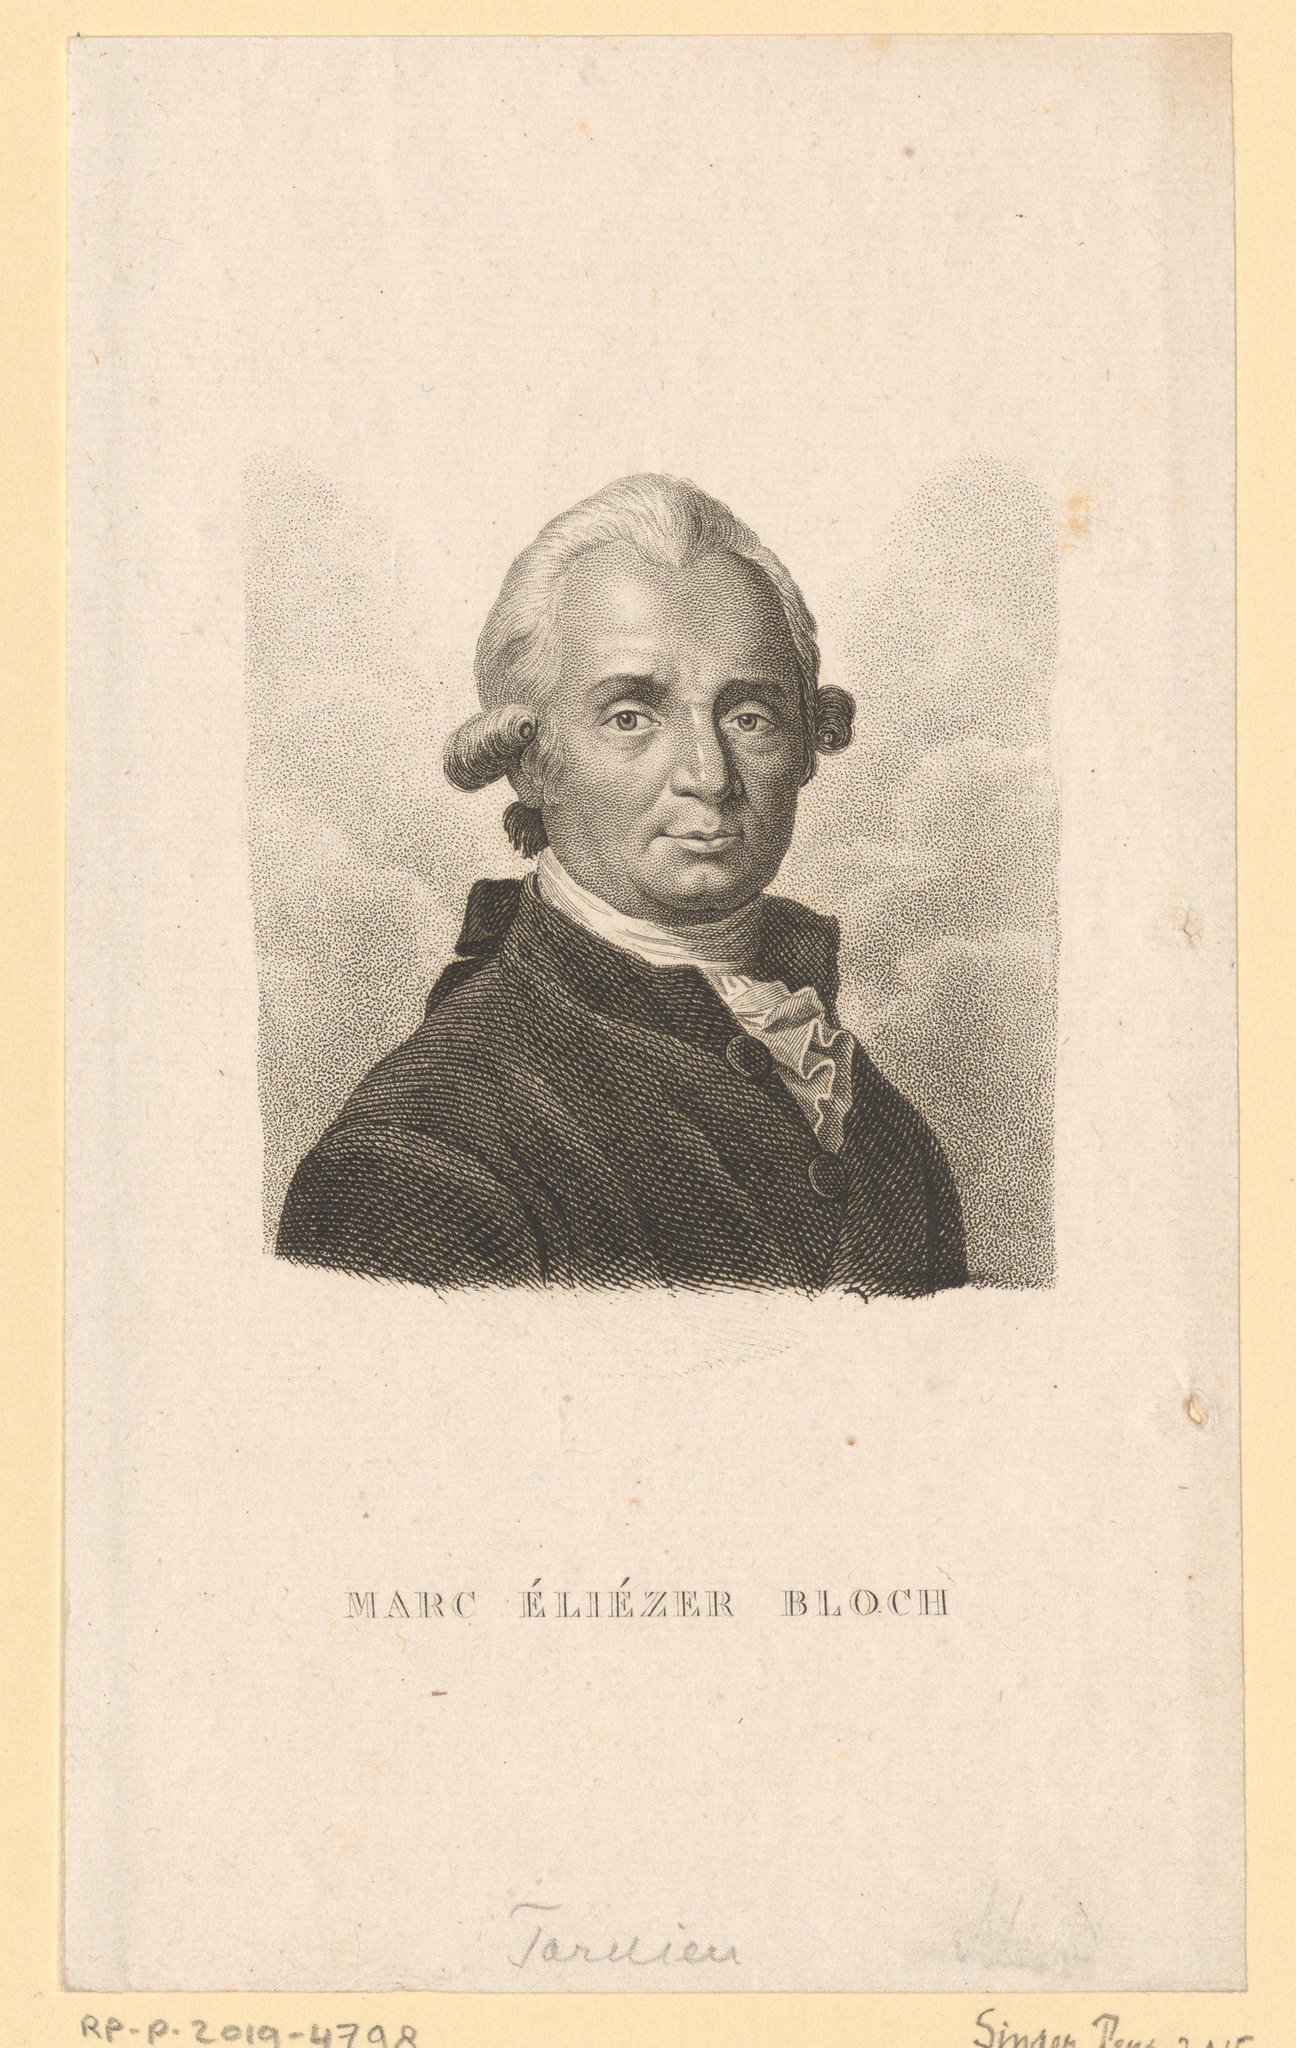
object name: print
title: Portret van Marcus Elieser Bloch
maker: ambroise tardieu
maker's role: print maker, printer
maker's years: 1788-1841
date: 1798-1841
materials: paper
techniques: engraving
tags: historical persons